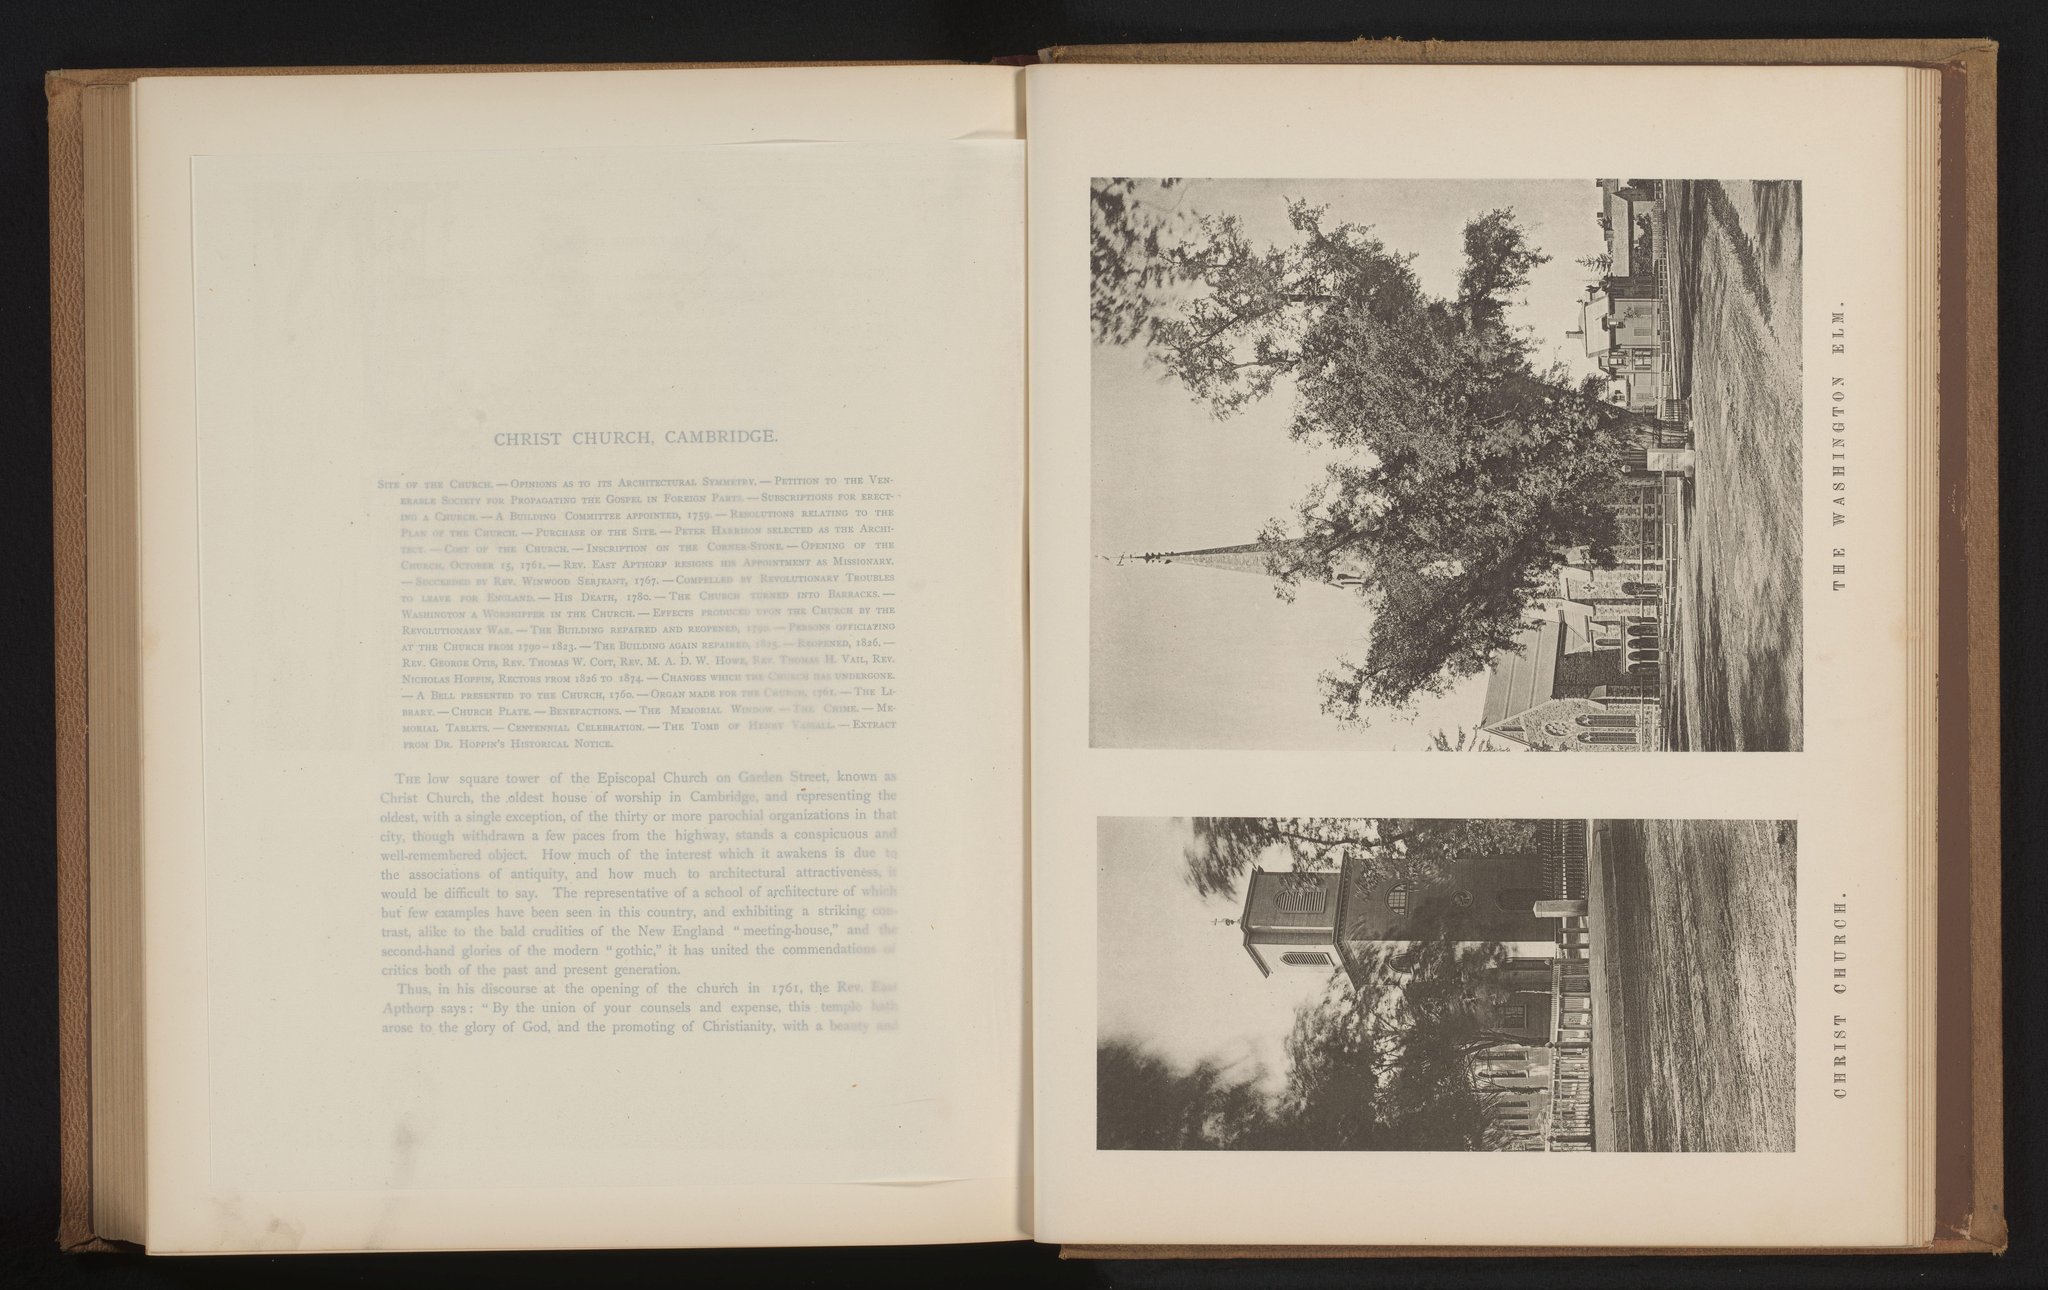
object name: photomechanical print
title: Gezicht op de Christ Church en de Washington Elm te Cambridge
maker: Anonymous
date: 1870-1875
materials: paper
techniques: photograph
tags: trees: elm, church (exterior)